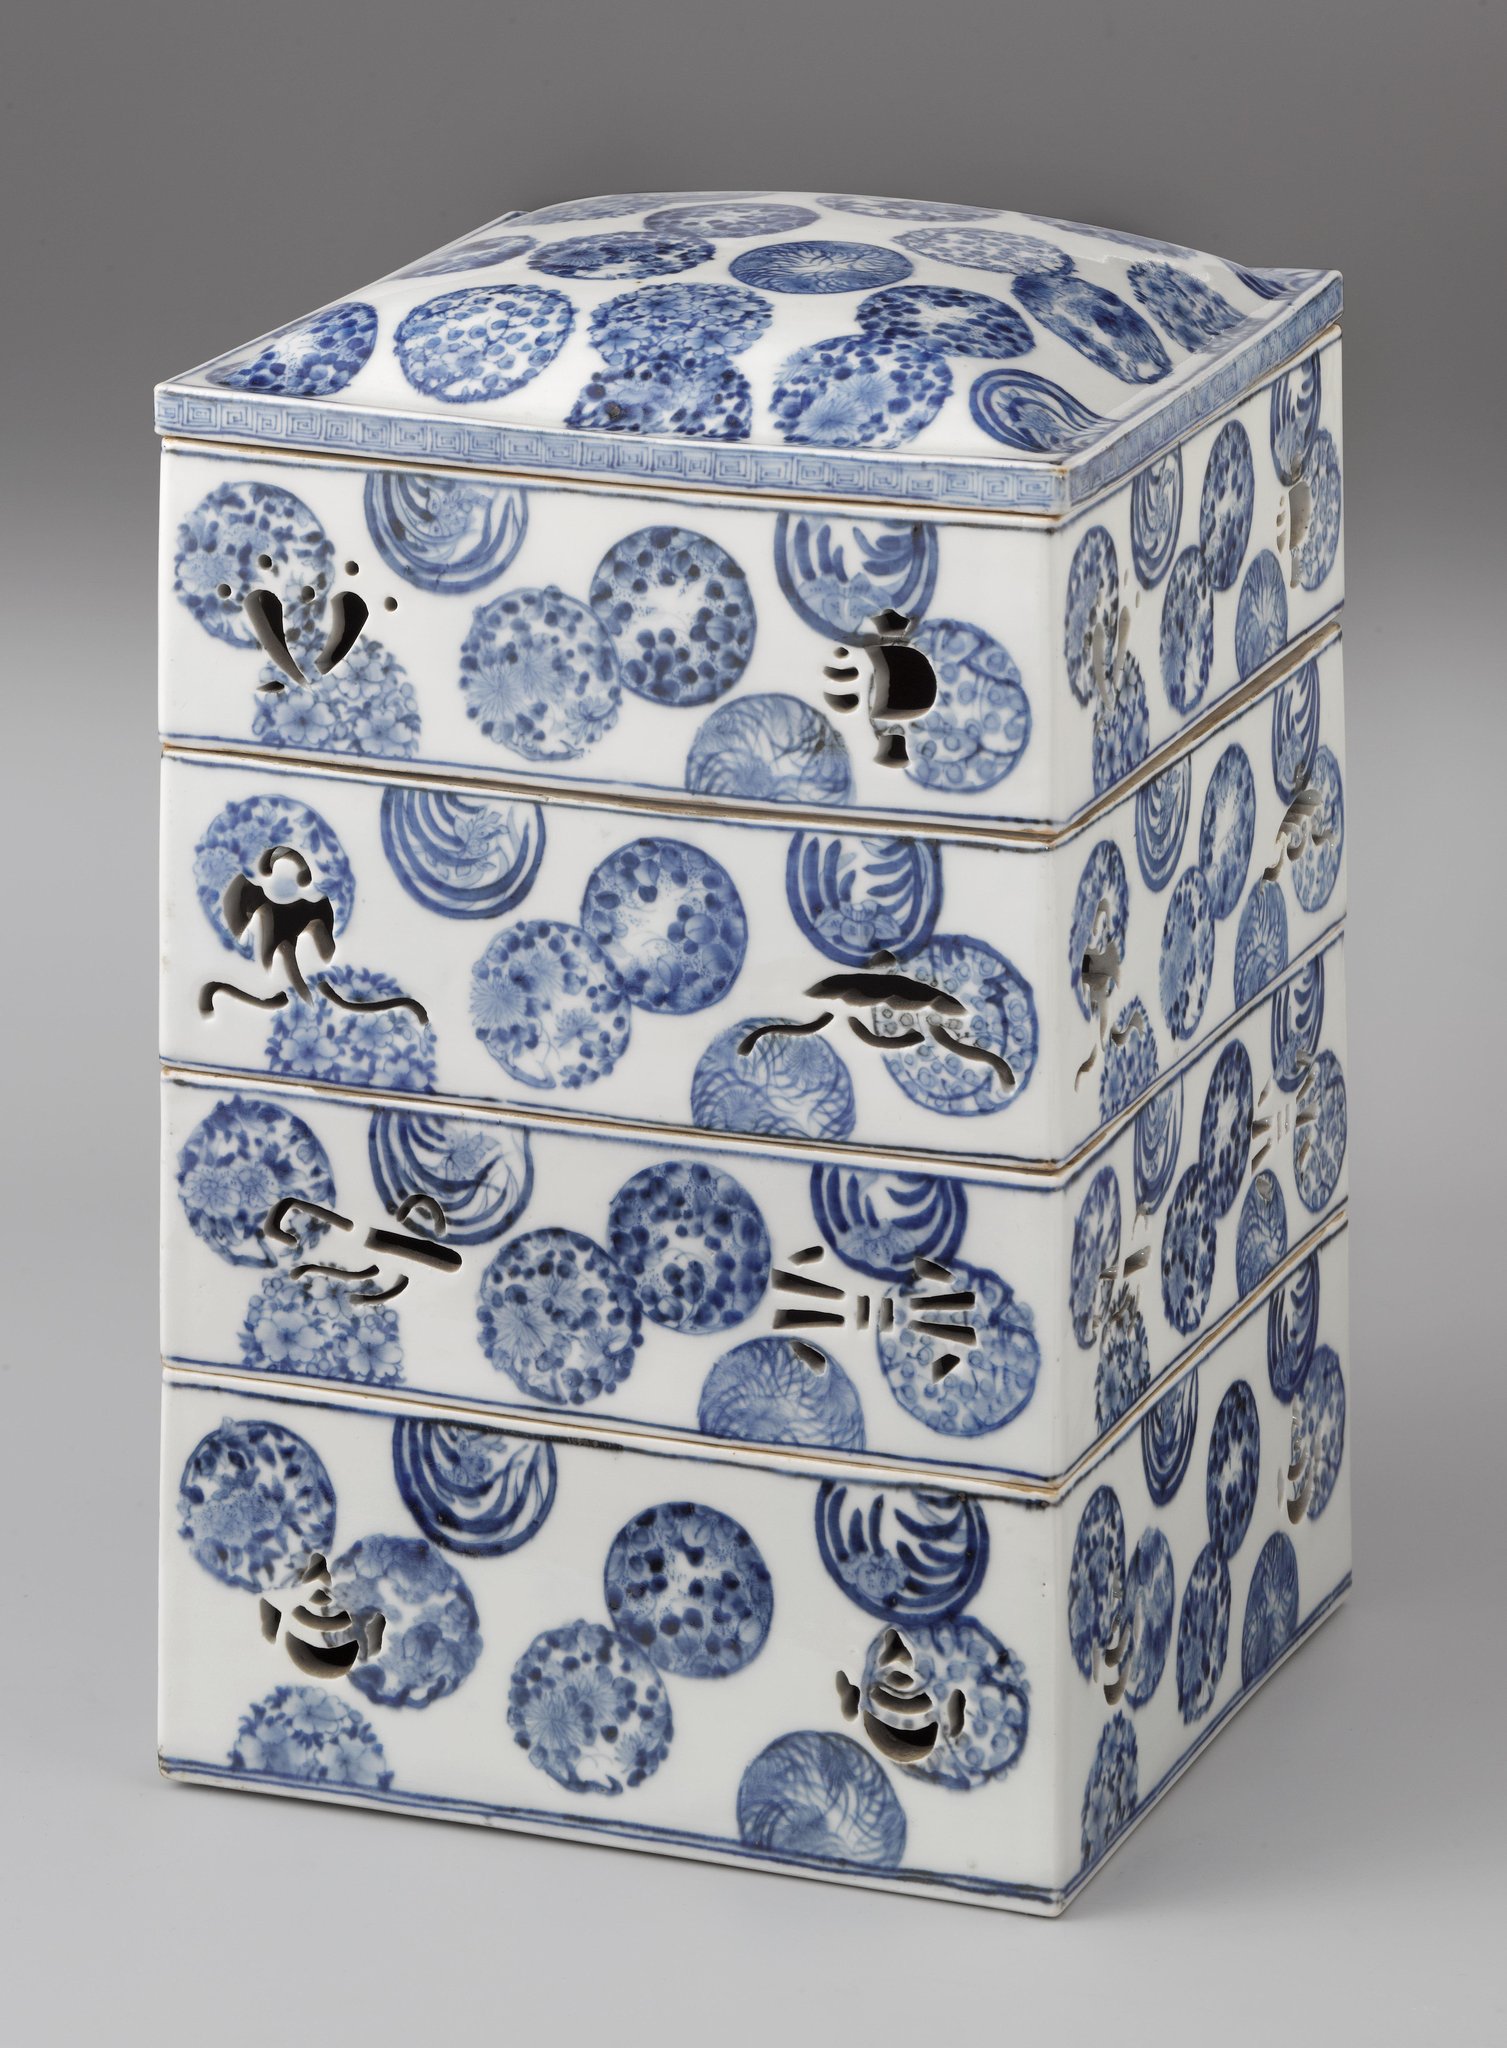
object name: box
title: Square tiered box with cover with medallions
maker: Anonymous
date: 1775-1824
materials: cobalt, glaze, paint, porcelain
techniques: embroidery, firing, forming, vitrification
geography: japan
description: Bovenste doos van vierkante stapeldoos (jubako) met deksel van porselein bestaande uit vier lagen met opengewerkte wanden in verschillende vormen, beschilderd in onderglazuur blauw. Op de wanden medaillons gevormd uit verschillende bloemranken (prunus, chrysant, pioen, orchidee, lelie, etc.). Op de rand van de deksel een meanderpatroon. Blauw-wit.